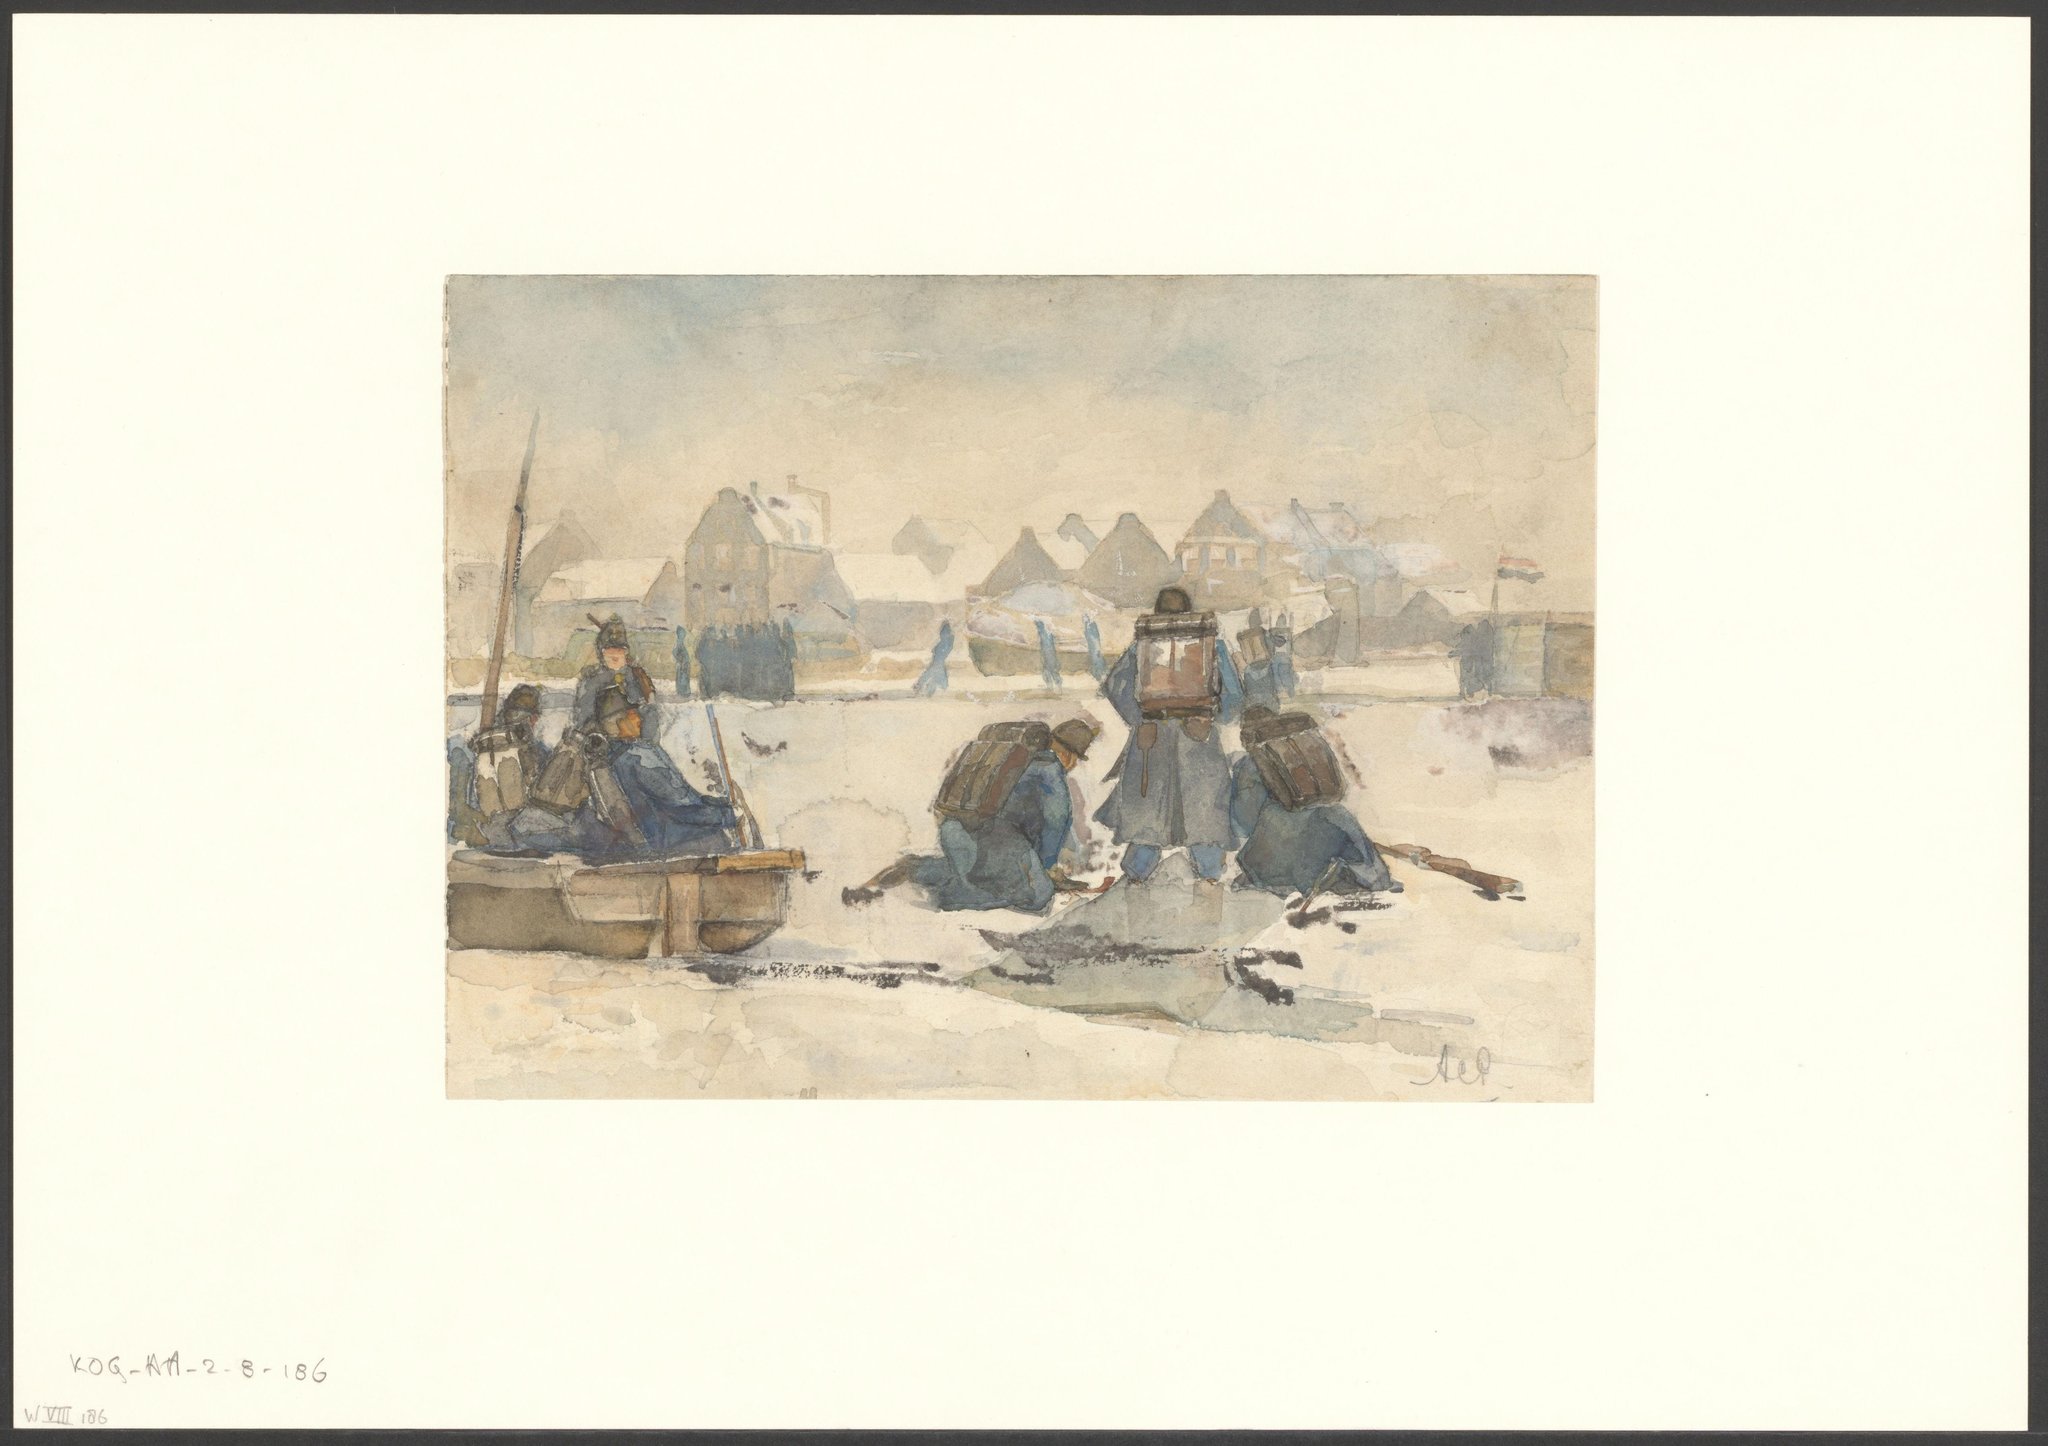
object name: drawing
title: Oefening van het 7e regiment bij de Buiten-Amstel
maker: Anonymous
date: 1890-1891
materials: ink, paper, pencil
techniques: brush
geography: amsterdam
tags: city-view in general; 'veduta', river, winter landscape; landscape symbolizing winter (the four seasons of the year)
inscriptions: inscription: ‘[...]Poort / Oefening 7e Regt. Buiten amstel’, date: ‘[...] 1890/1891’, signature: ‘[...]’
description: Tekening binnen de Atlas Van Eck ingedeeld op wijknummer 8.